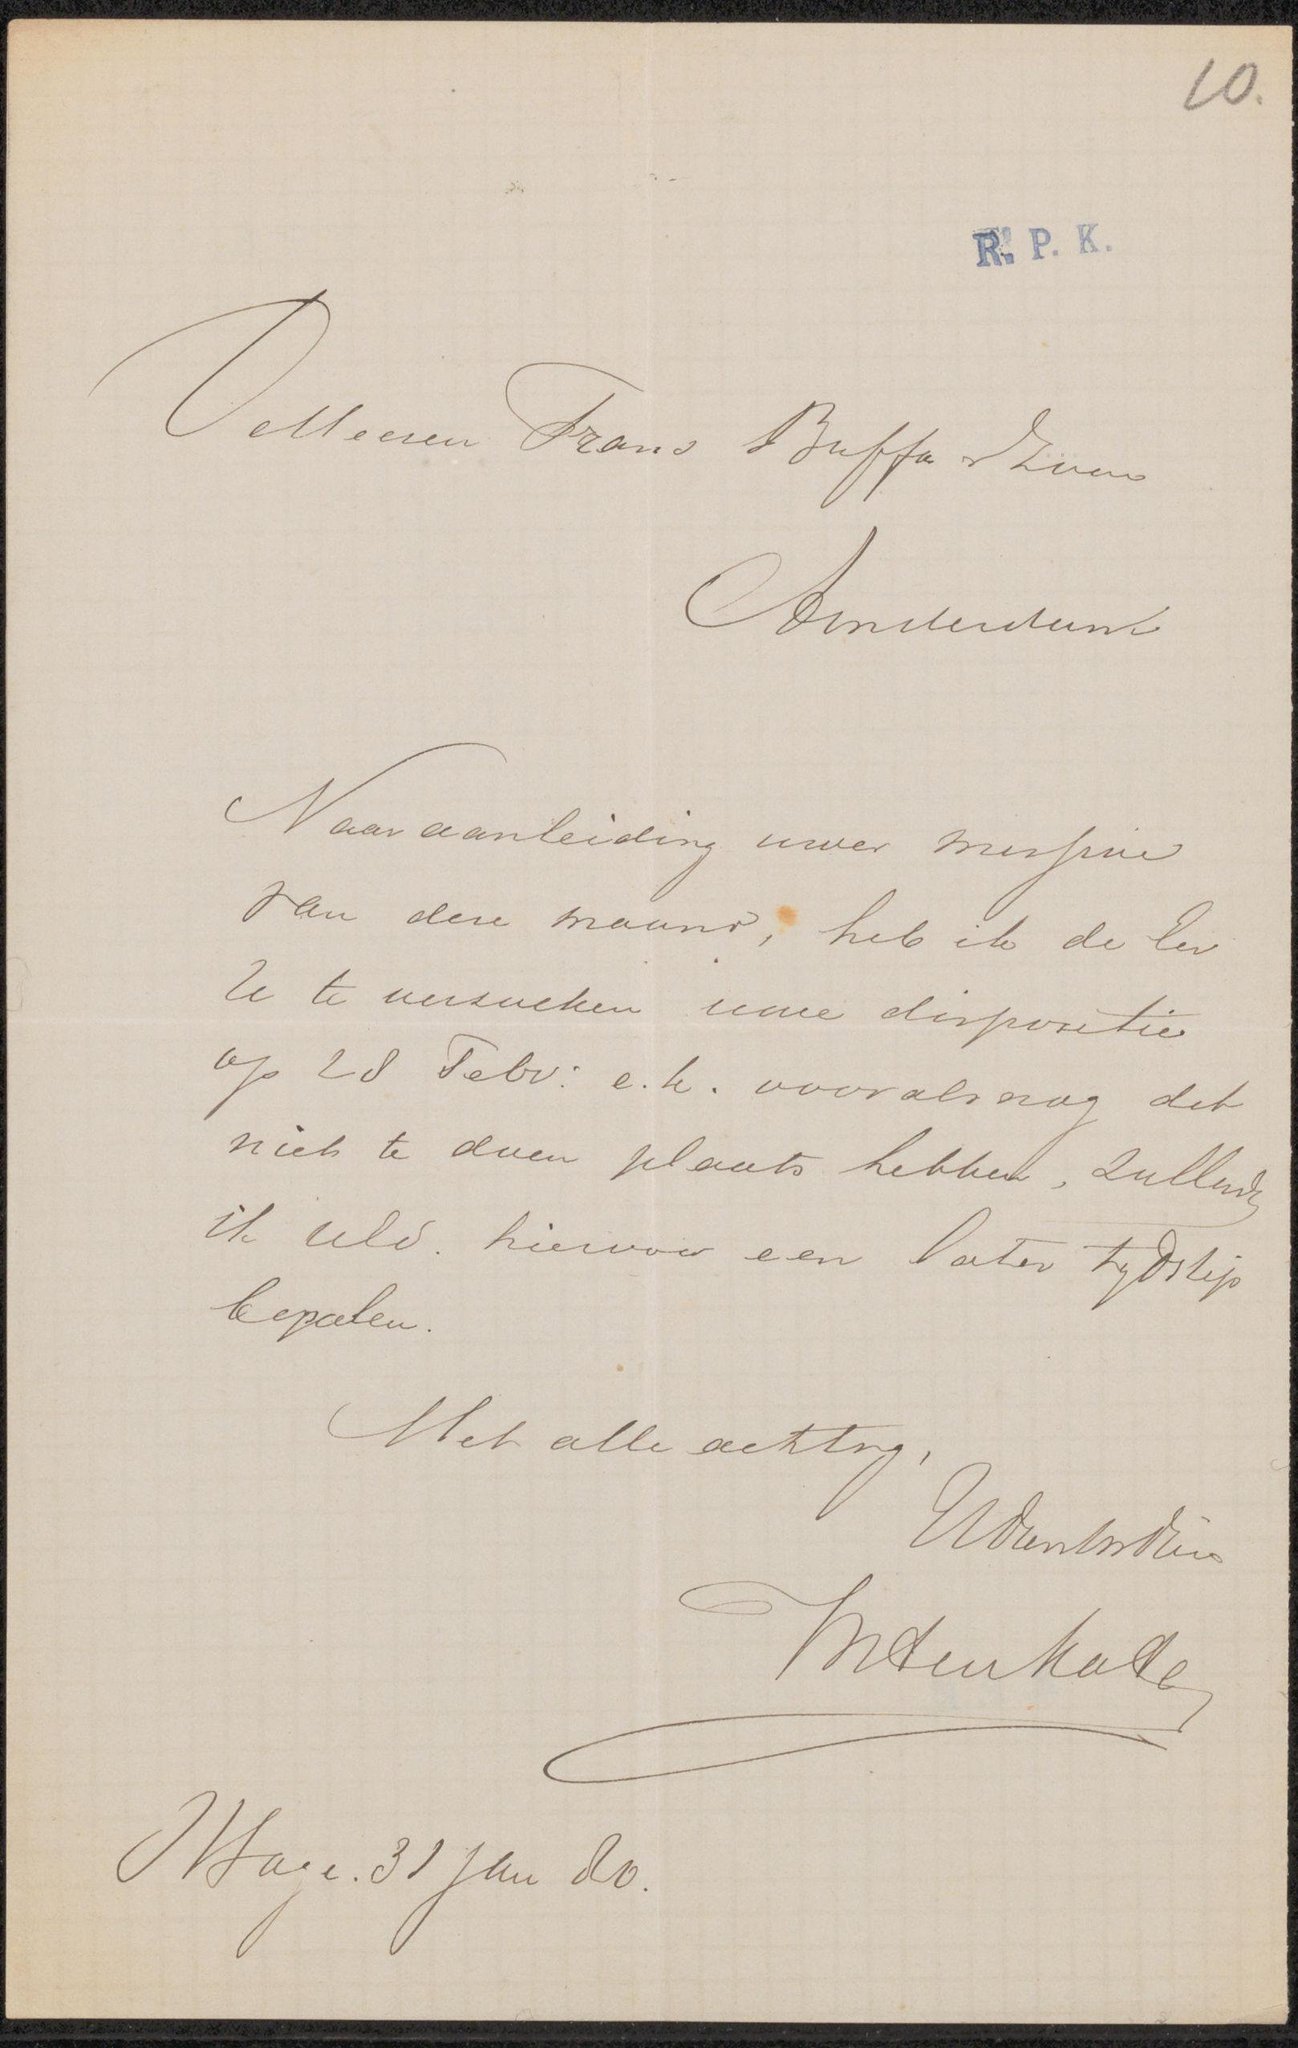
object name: letter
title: Brief aan Frans Buffa en Zonen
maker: mari ten kate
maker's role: draughtsman, painter, print maker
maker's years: 1831-1910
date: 1880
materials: ink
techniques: pen, writing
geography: the hague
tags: publisher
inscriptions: collector's mark: Lugt 2233